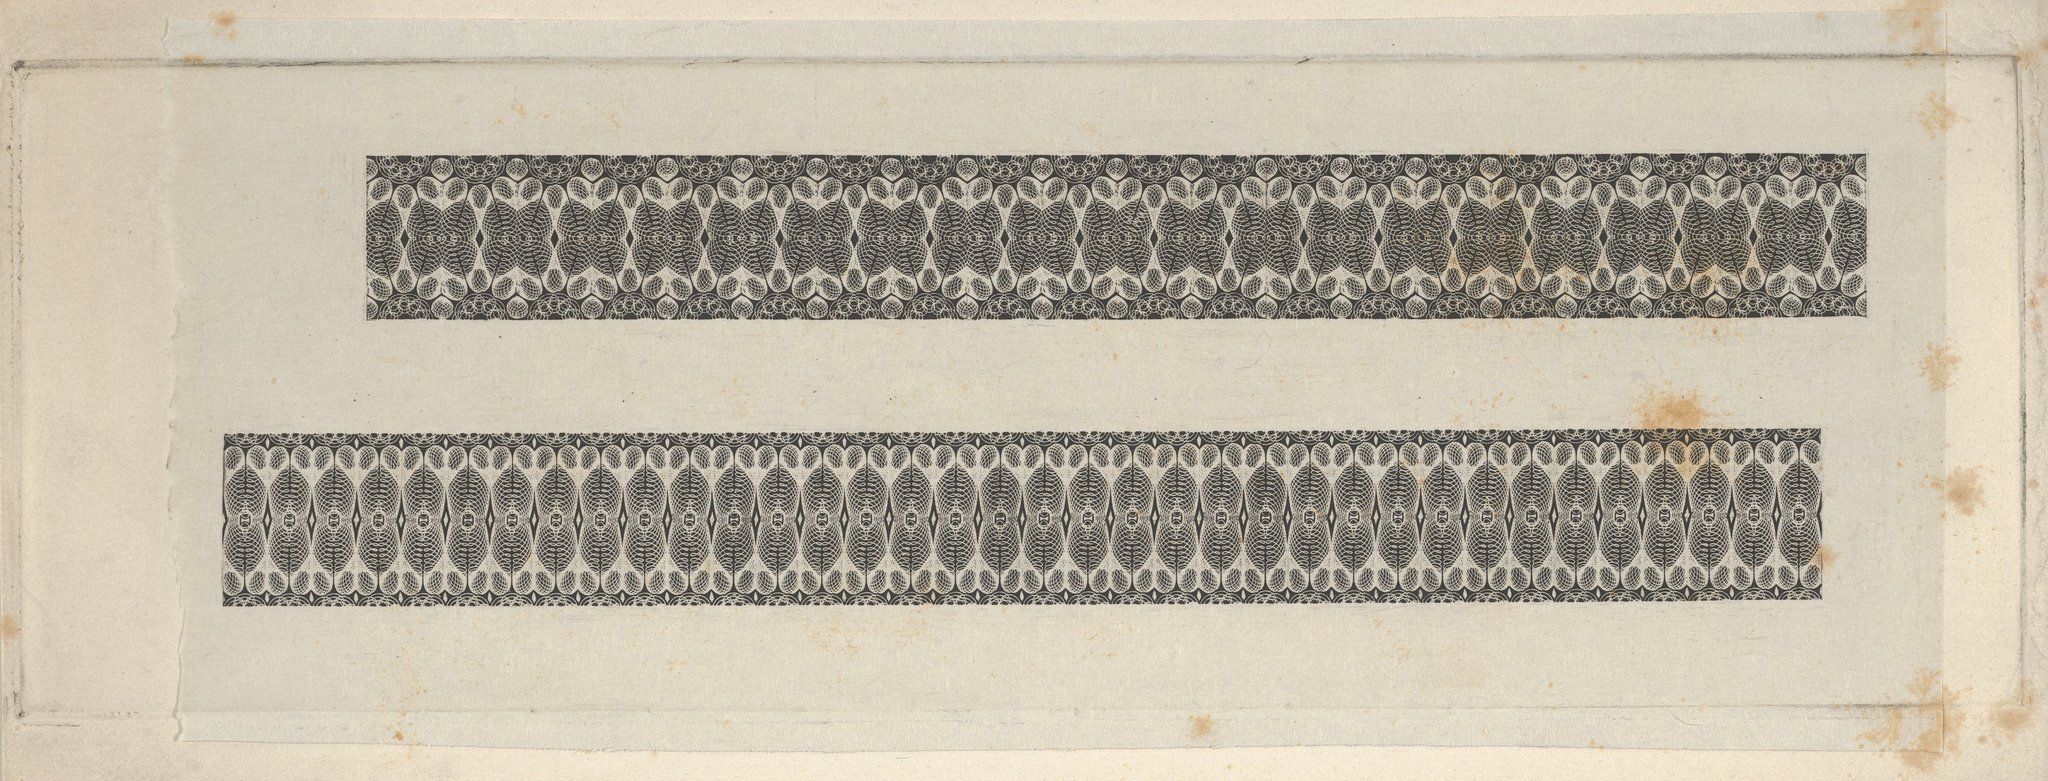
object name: print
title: Banknote motifs: two bands of lathe work ornament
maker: cyrus durand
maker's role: artist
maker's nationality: american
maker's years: 1787-1868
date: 1824-1842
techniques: printmaking, engraving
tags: ornament